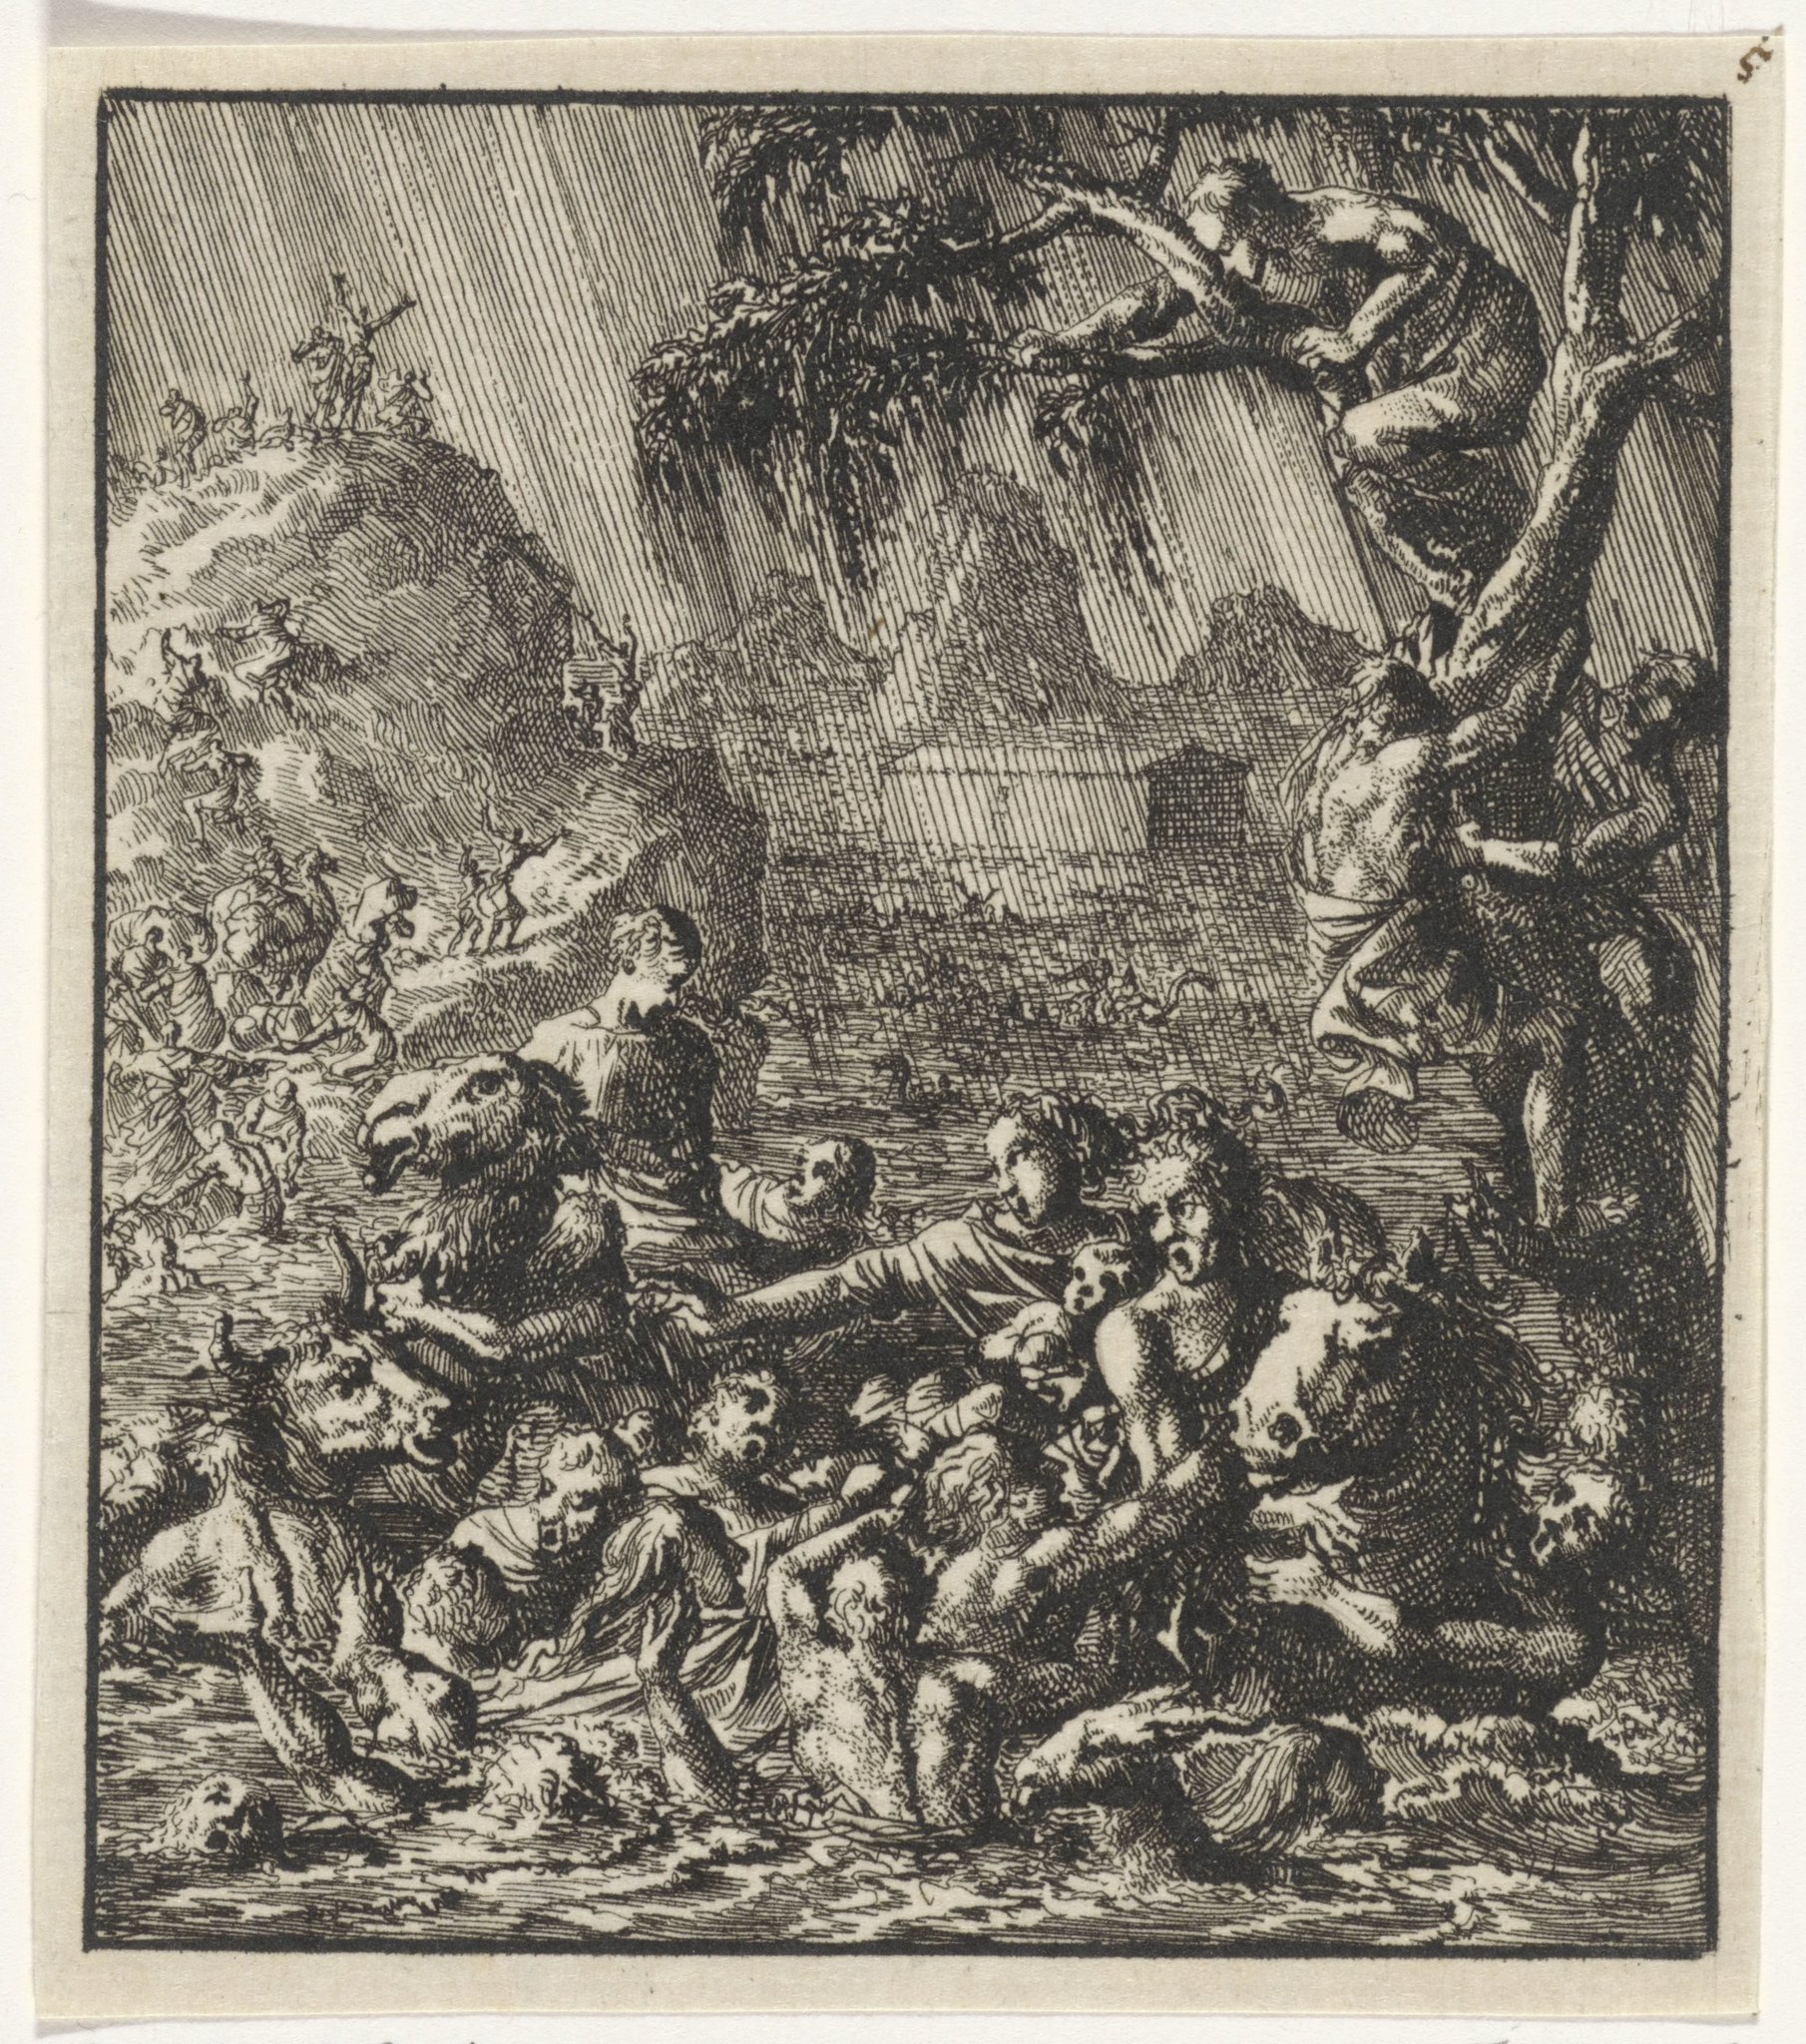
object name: print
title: Zondvloed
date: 1706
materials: paper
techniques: etching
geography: amsterdam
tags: the flood and destruction of mankind ~ story of noah (genesis 7:10 - 8:17)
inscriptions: collector's mark: Lugt 2228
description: Illustratie voor: Schabaalje, Jean Philipsz. De vermeerderde lust-hof des gemoeds. Amsterdam: Jan Rieuwertsz. (II) en Barent Visscher, 1706, p. 120.